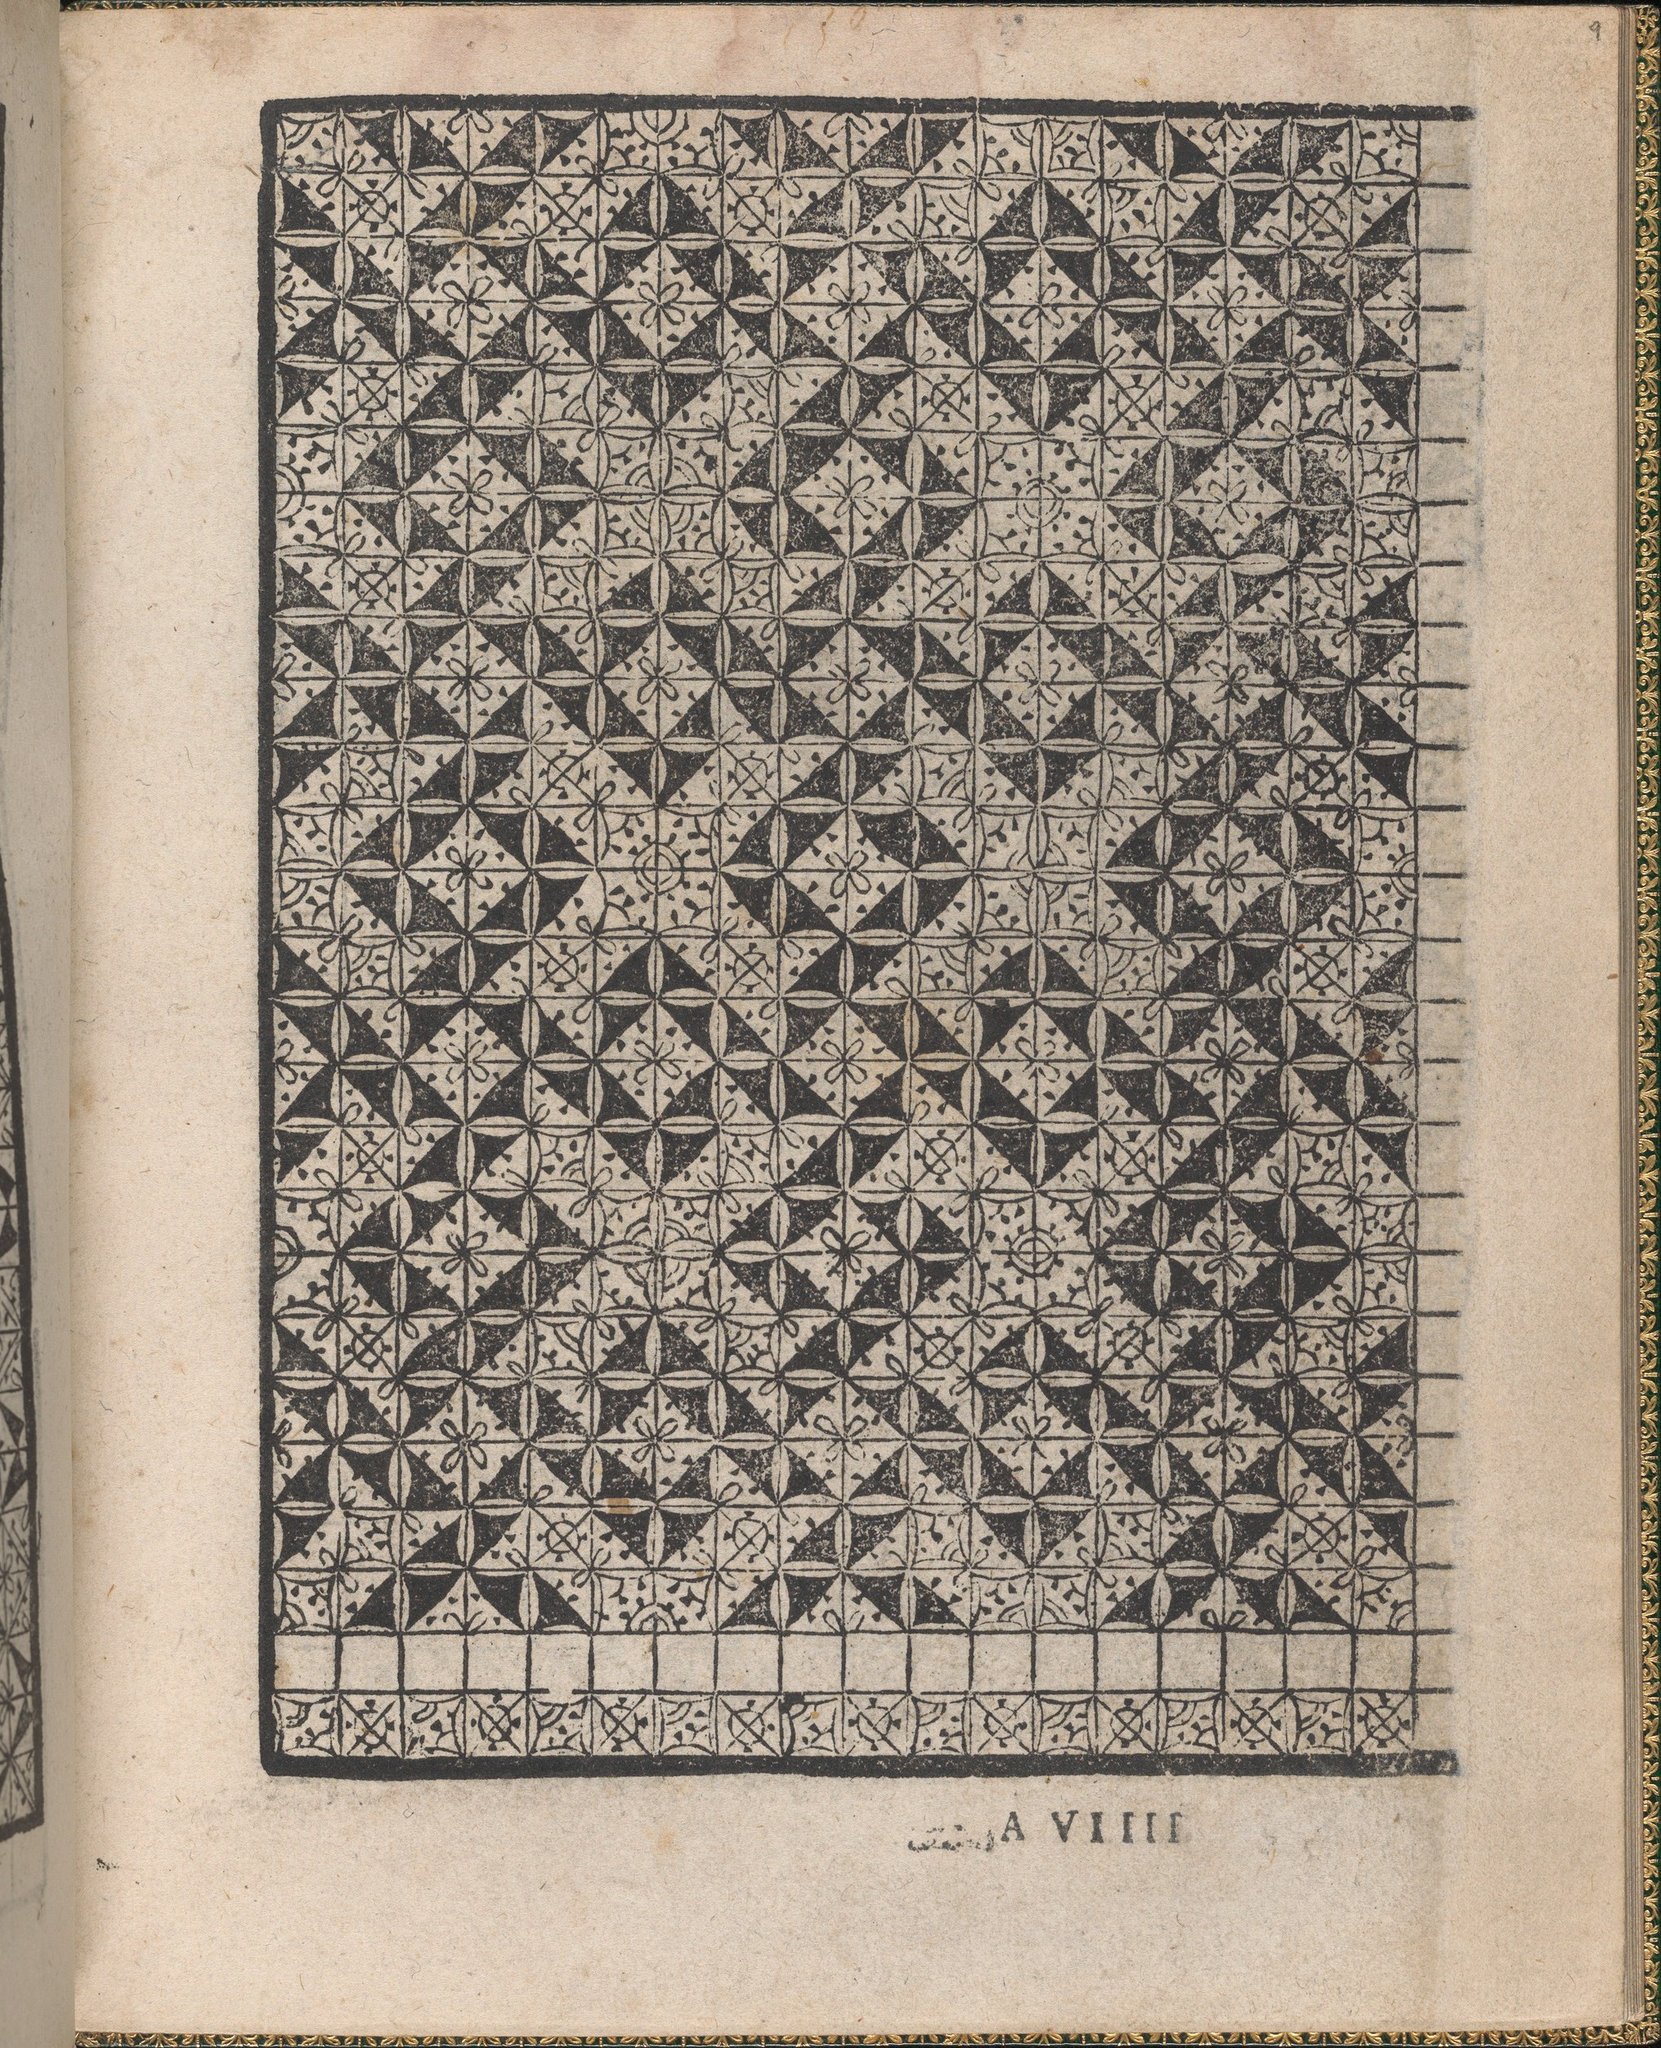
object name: book print ornament architecture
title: Ornamento delle belle & virtuose donne, page 5 (verso)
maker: matteo pagano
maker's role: publisher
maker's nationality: italian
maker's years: 1515-1588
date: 1554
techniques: woodcut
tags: ornament